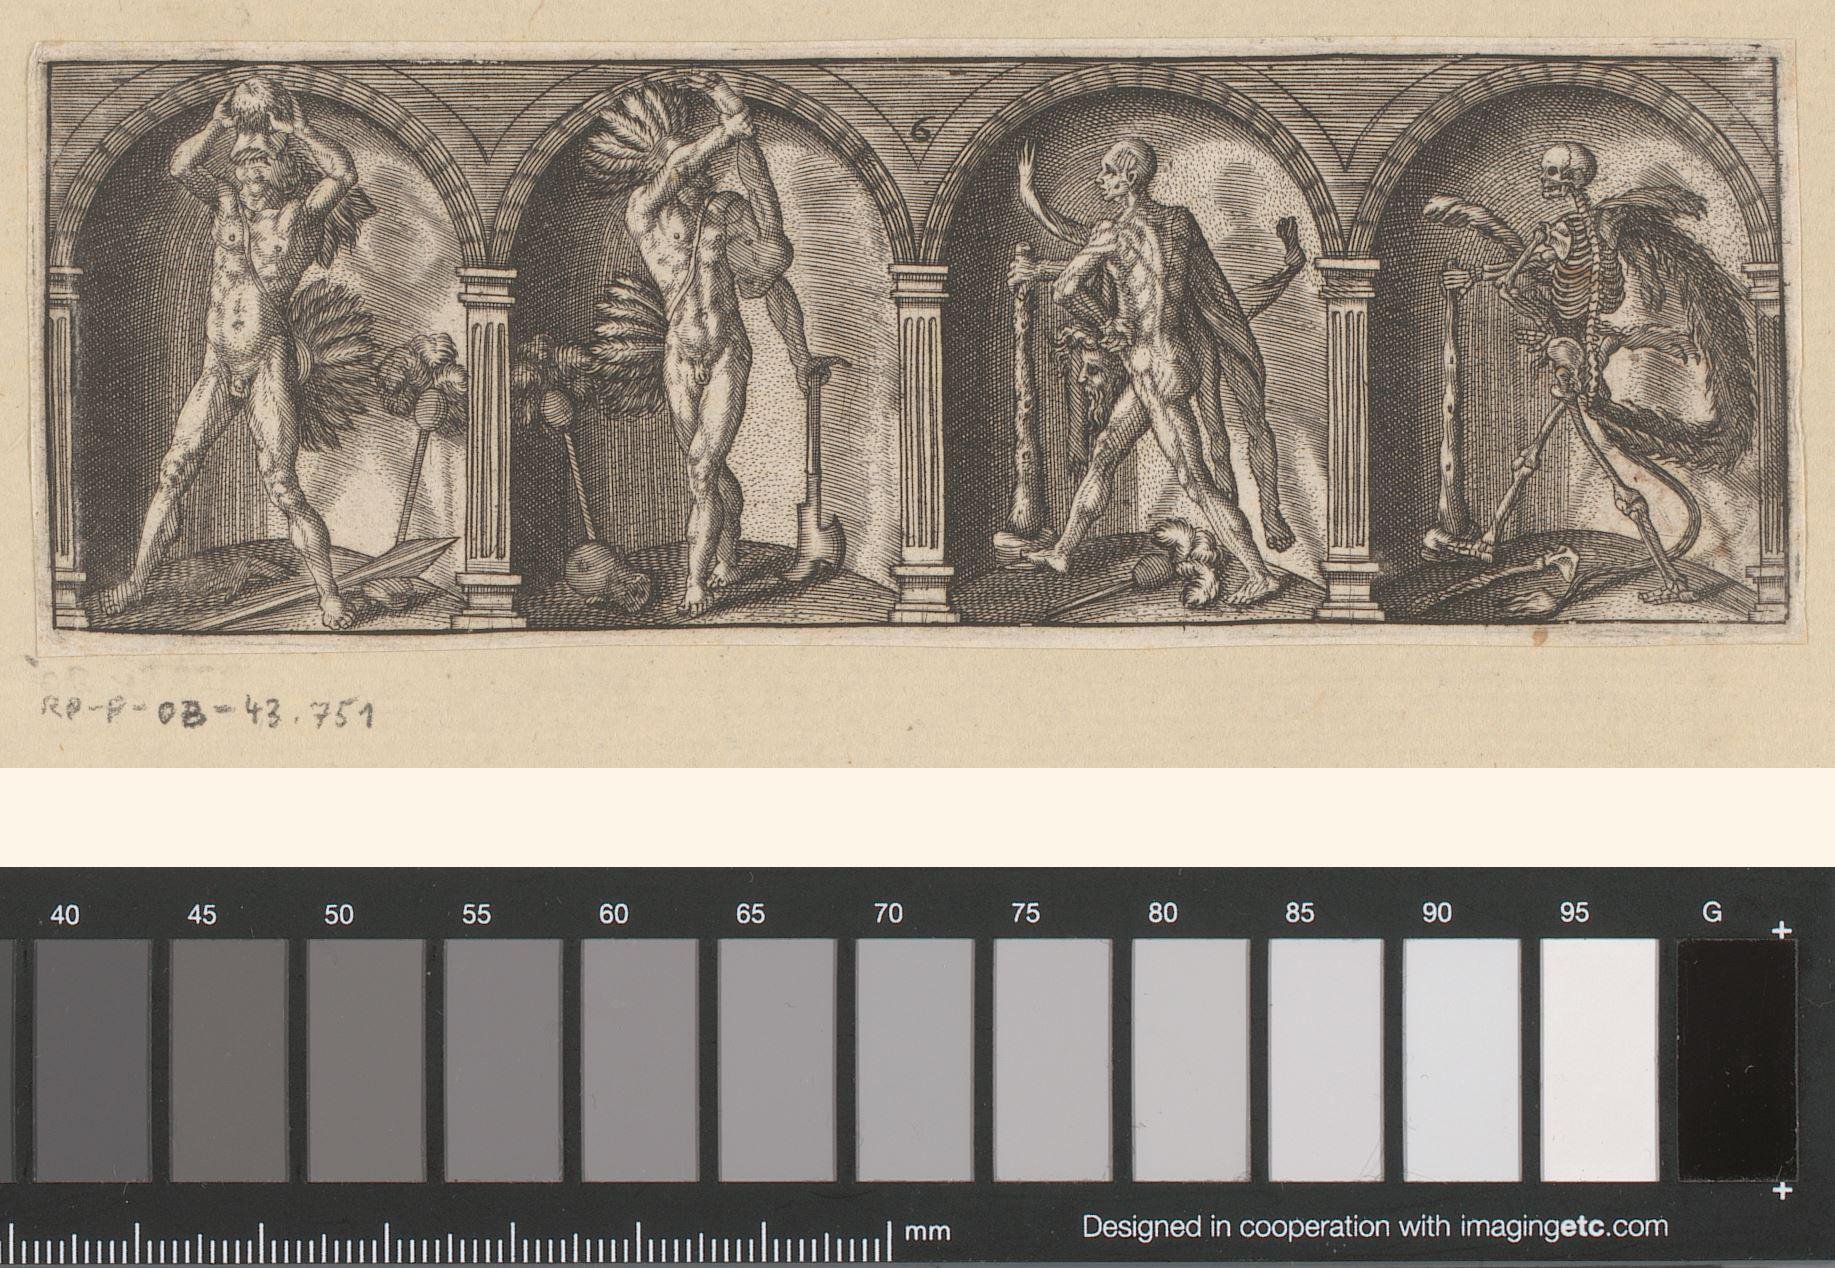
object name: print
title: Vier figuren in niches, elk in een ander stadium van ontleding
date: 1610-1640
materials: paper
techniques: engraving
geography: france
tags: parts of church interior: niche, decomposition (of dead body)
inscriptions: collector's mark: Lugt 240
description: In deze serie worden naakte figuren in vier architecturale niches geplaatst. Zij stellen de inwoners voor van de Nieuwe Wereld.